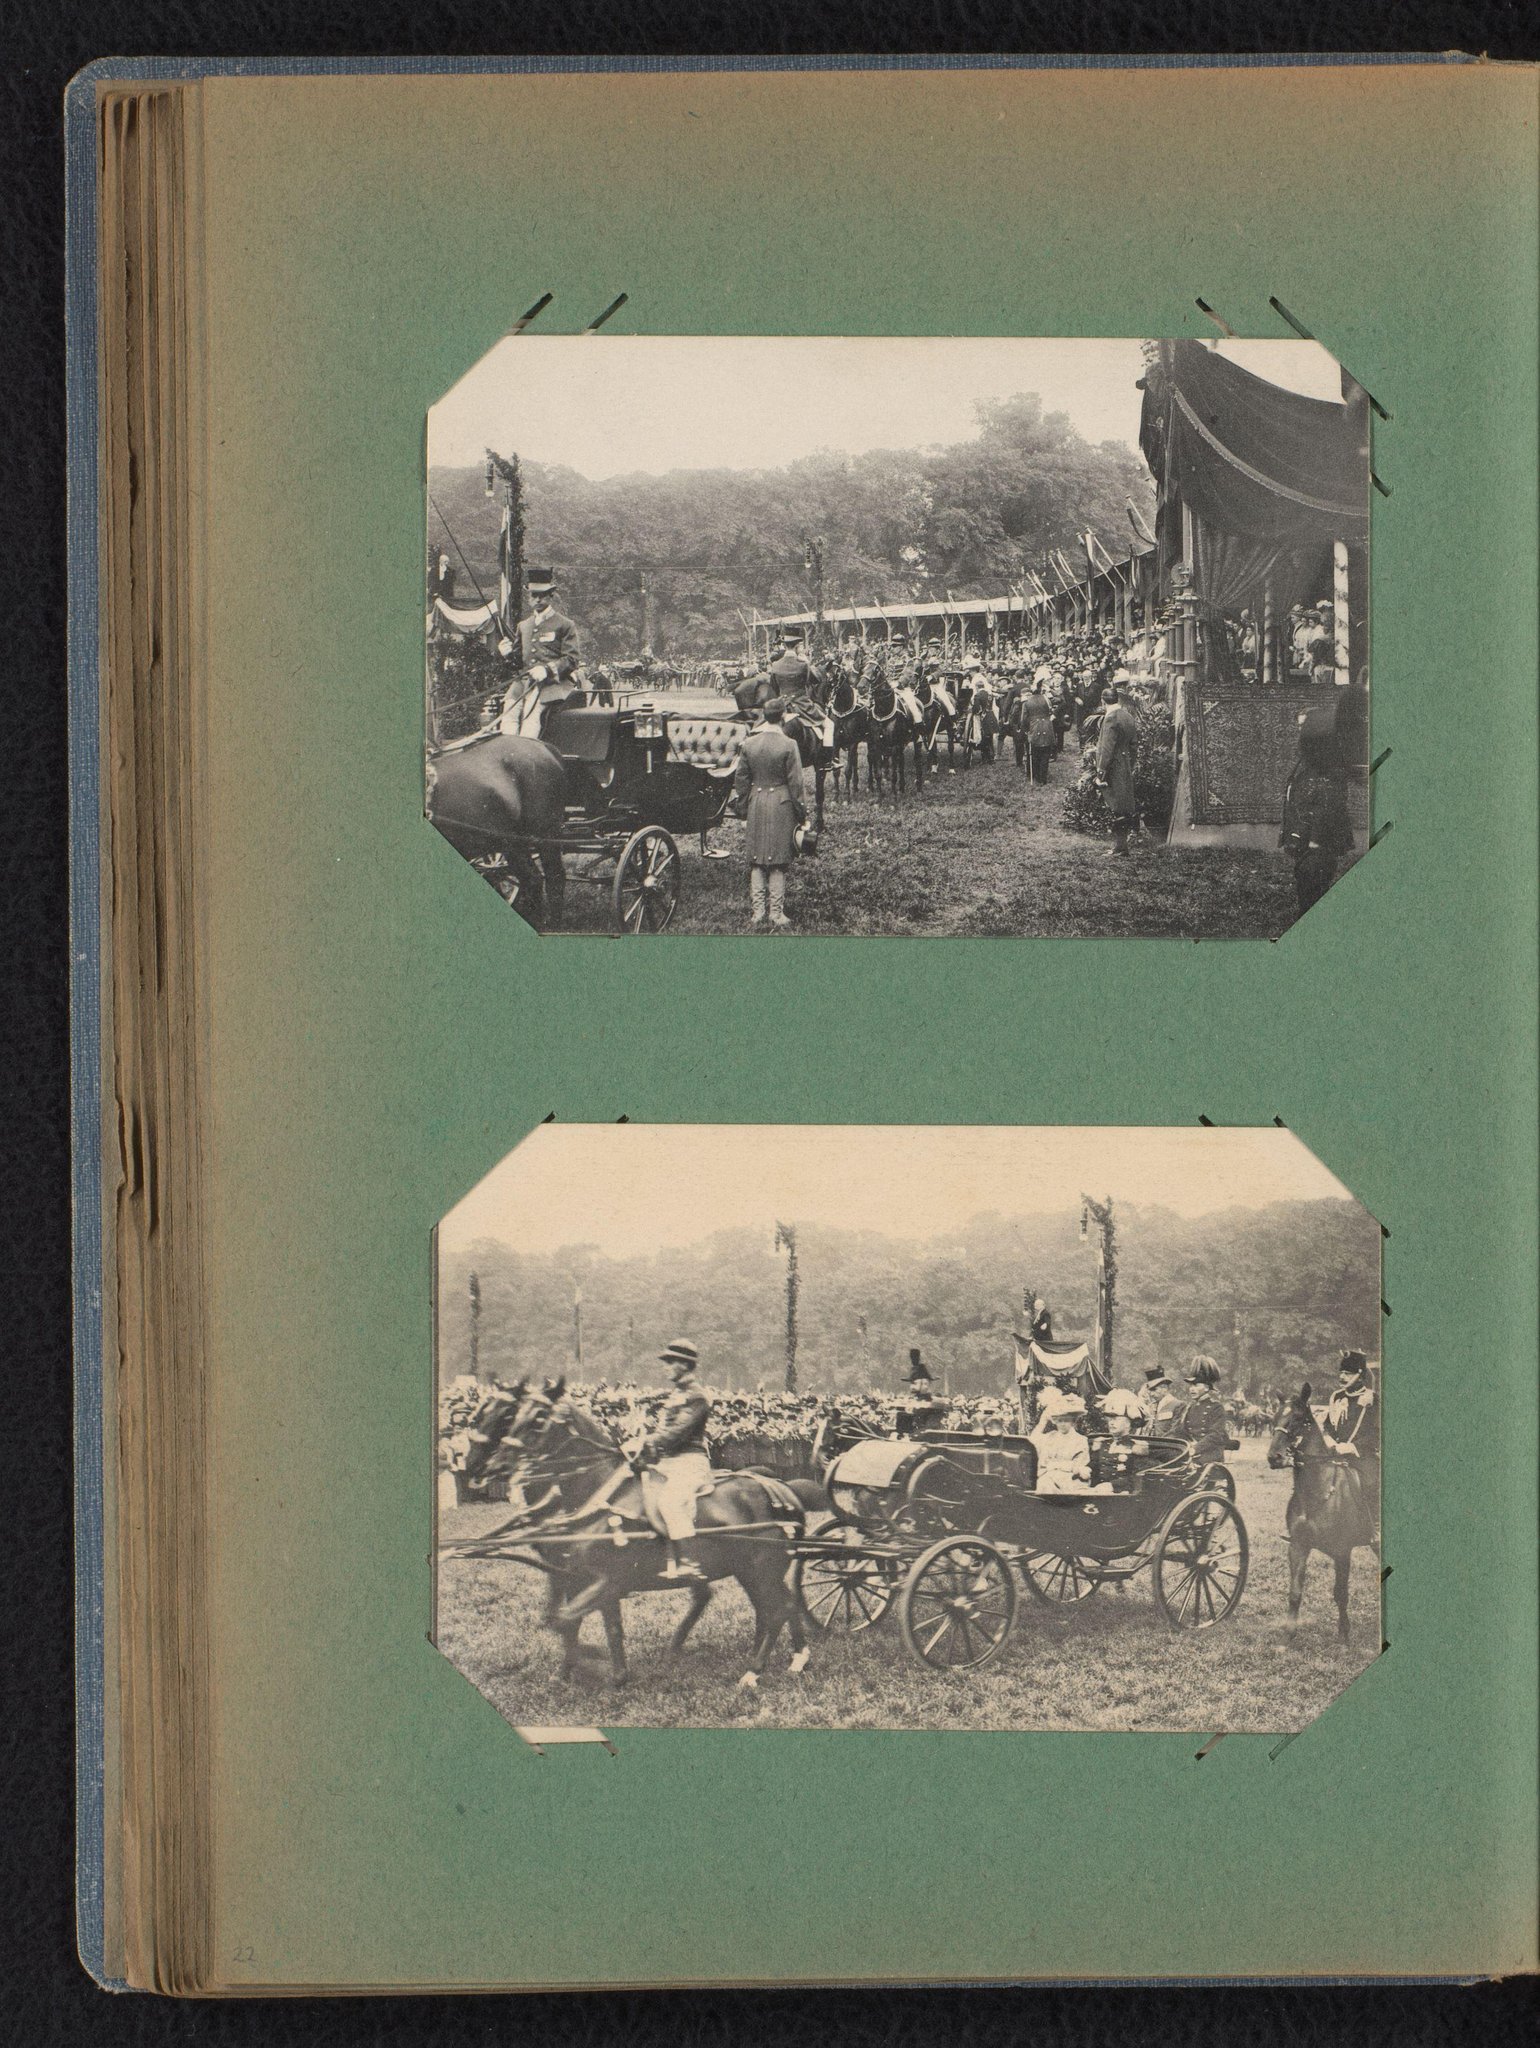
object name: photomechanical print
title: Twee prentbriefkaarten van de aubade ter ere van de geboorte van prinses Juliana op 8 juni 1909 in Den Haag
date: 1909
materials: cardboard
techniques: photograph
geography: the hague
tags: public festivities at birth of royal persons, four-wheeled vehicle drawn by two animals, the hague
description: Deze prenten maken deel uit van een album.